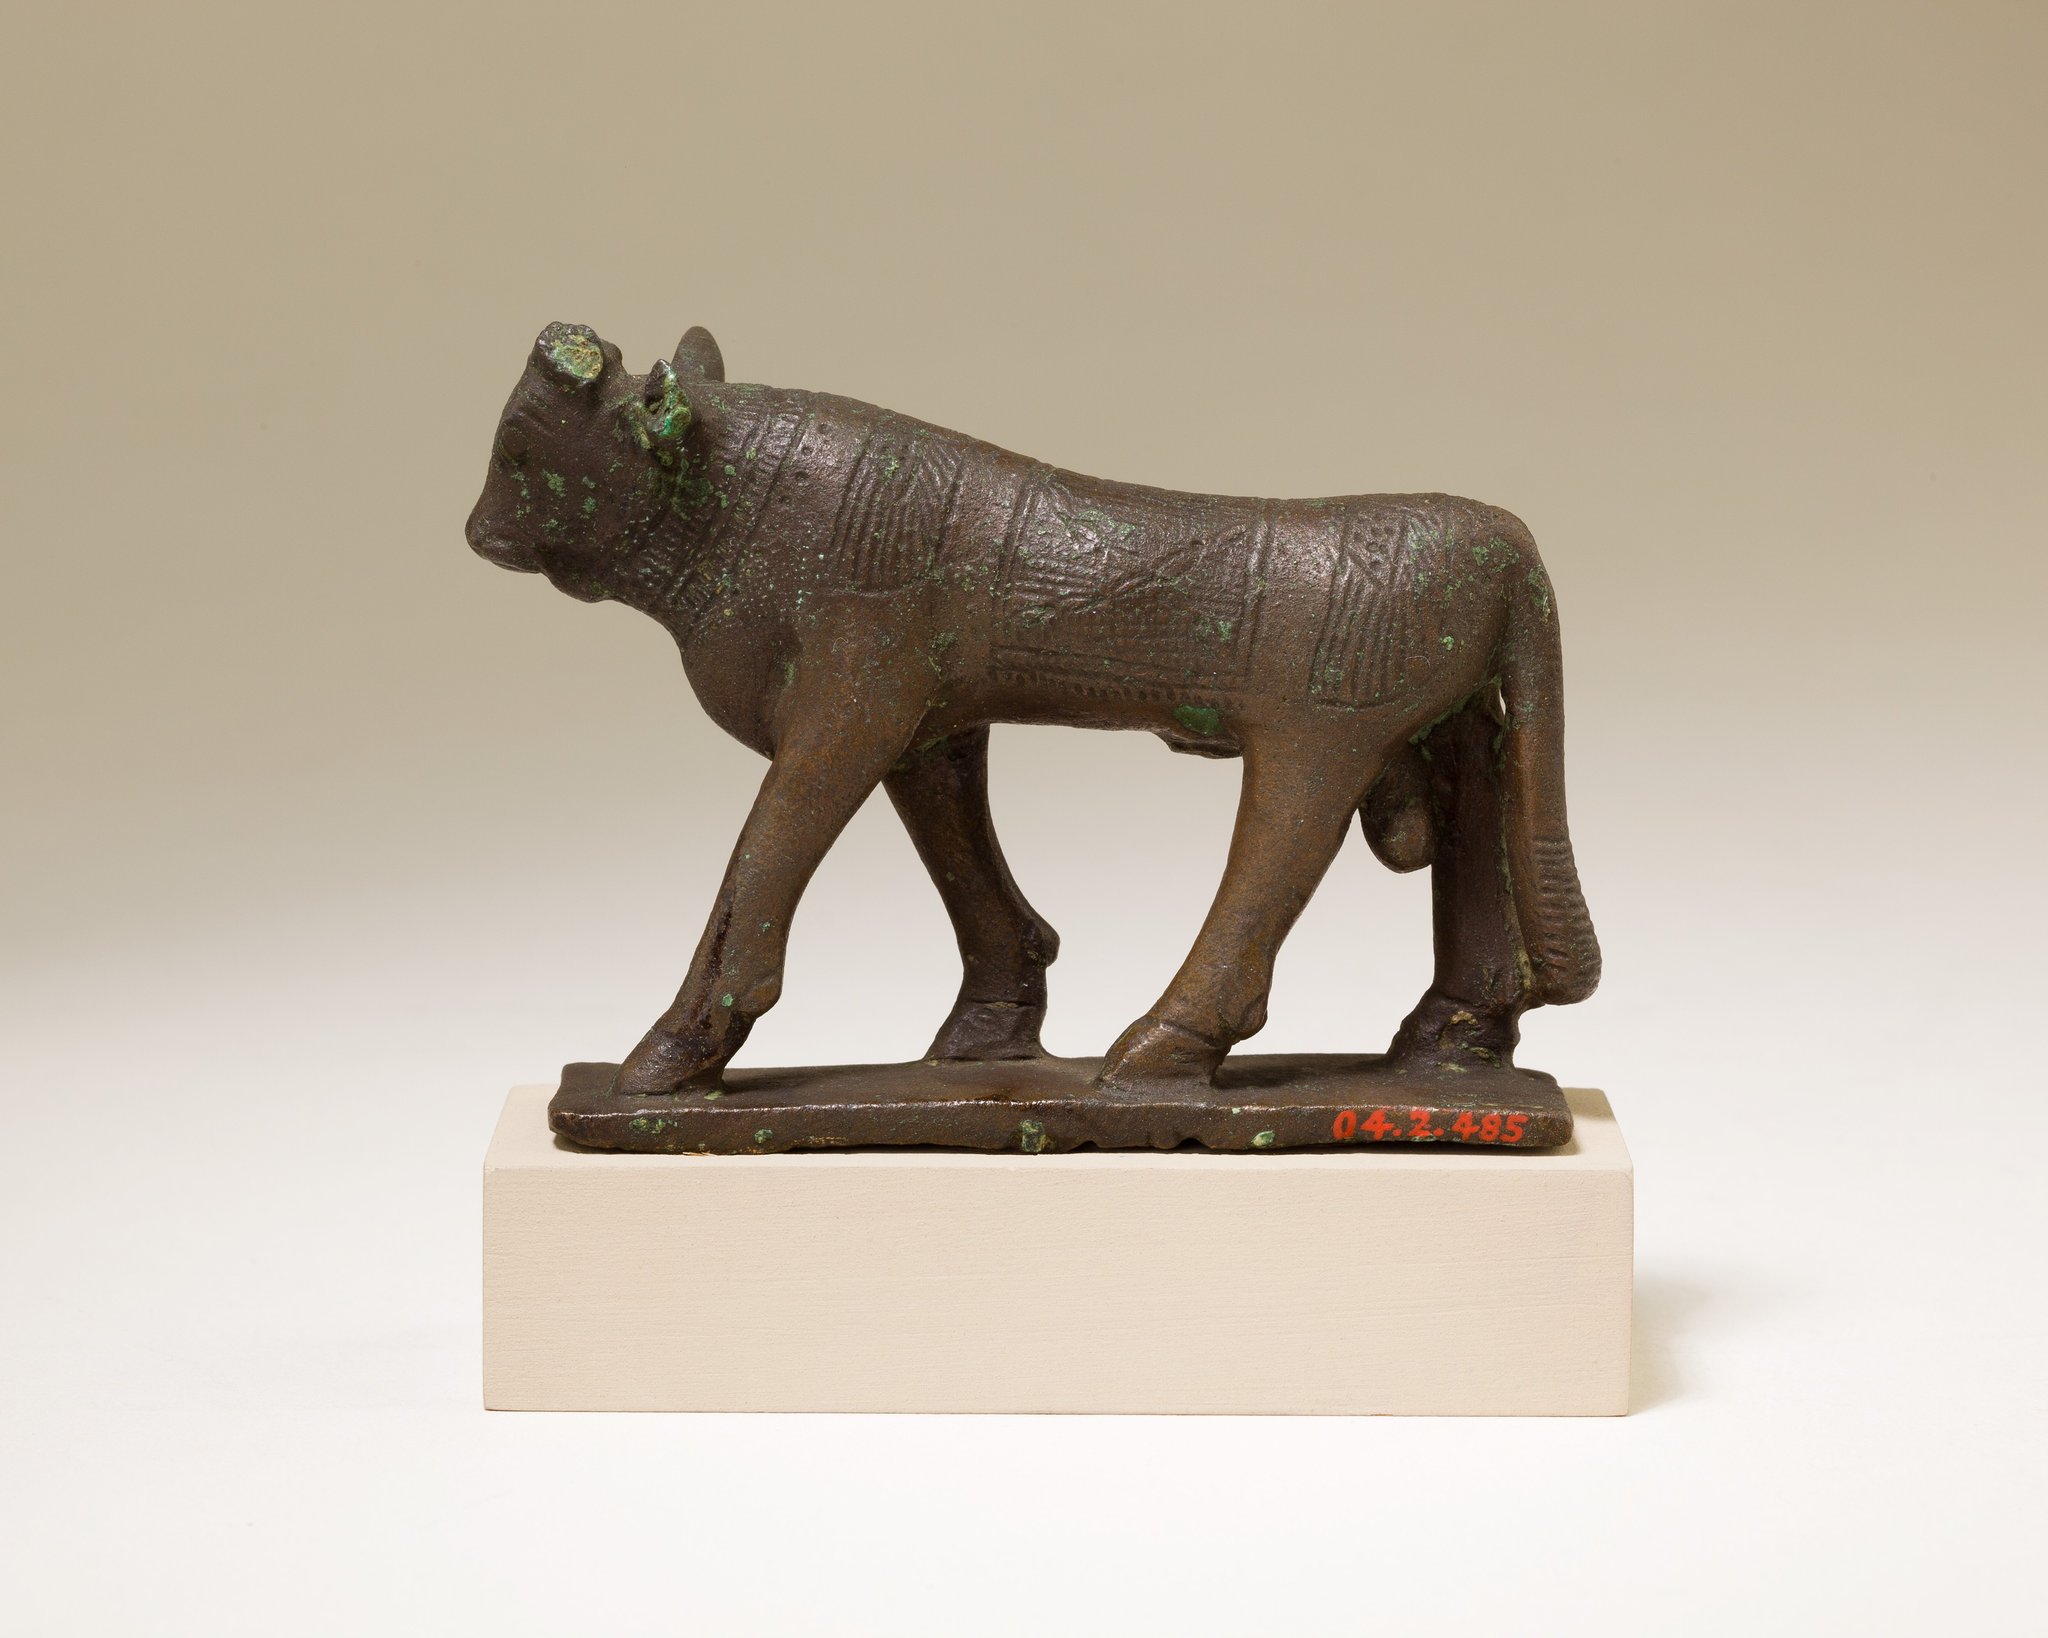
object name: figurine, apis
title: Apis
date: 664-630 BCE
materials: metal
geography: egypt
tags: animals